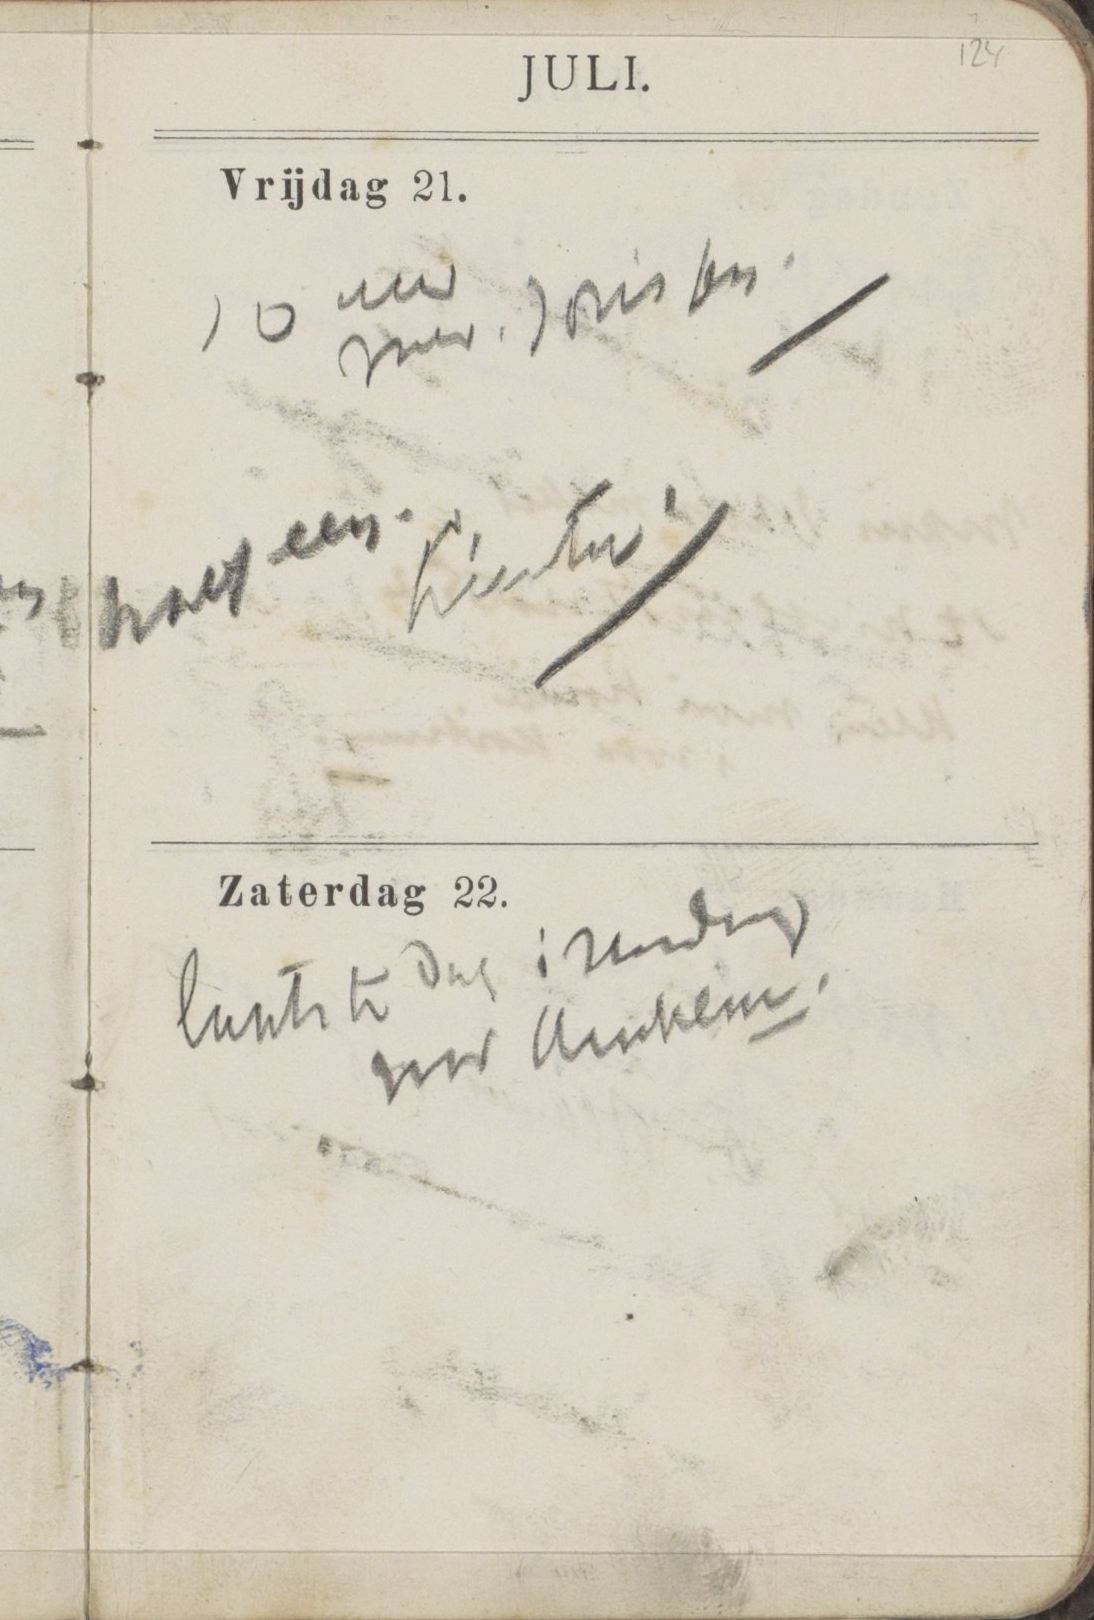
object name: sketchbook leaf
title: Annotaties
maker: george hendrik breitner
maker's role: draughtsman, painter, print maker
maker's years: 1857-1923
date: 1893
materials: chalk, paper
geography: amsterdam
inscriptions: annotation: ‘10 uur mev. Jorissen. half een/ Lientje/ laatste dag inzending/ naar Arnhem.’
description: Pagina 124 uit een als schetsboek gebruikte agenda met 108 bladen.